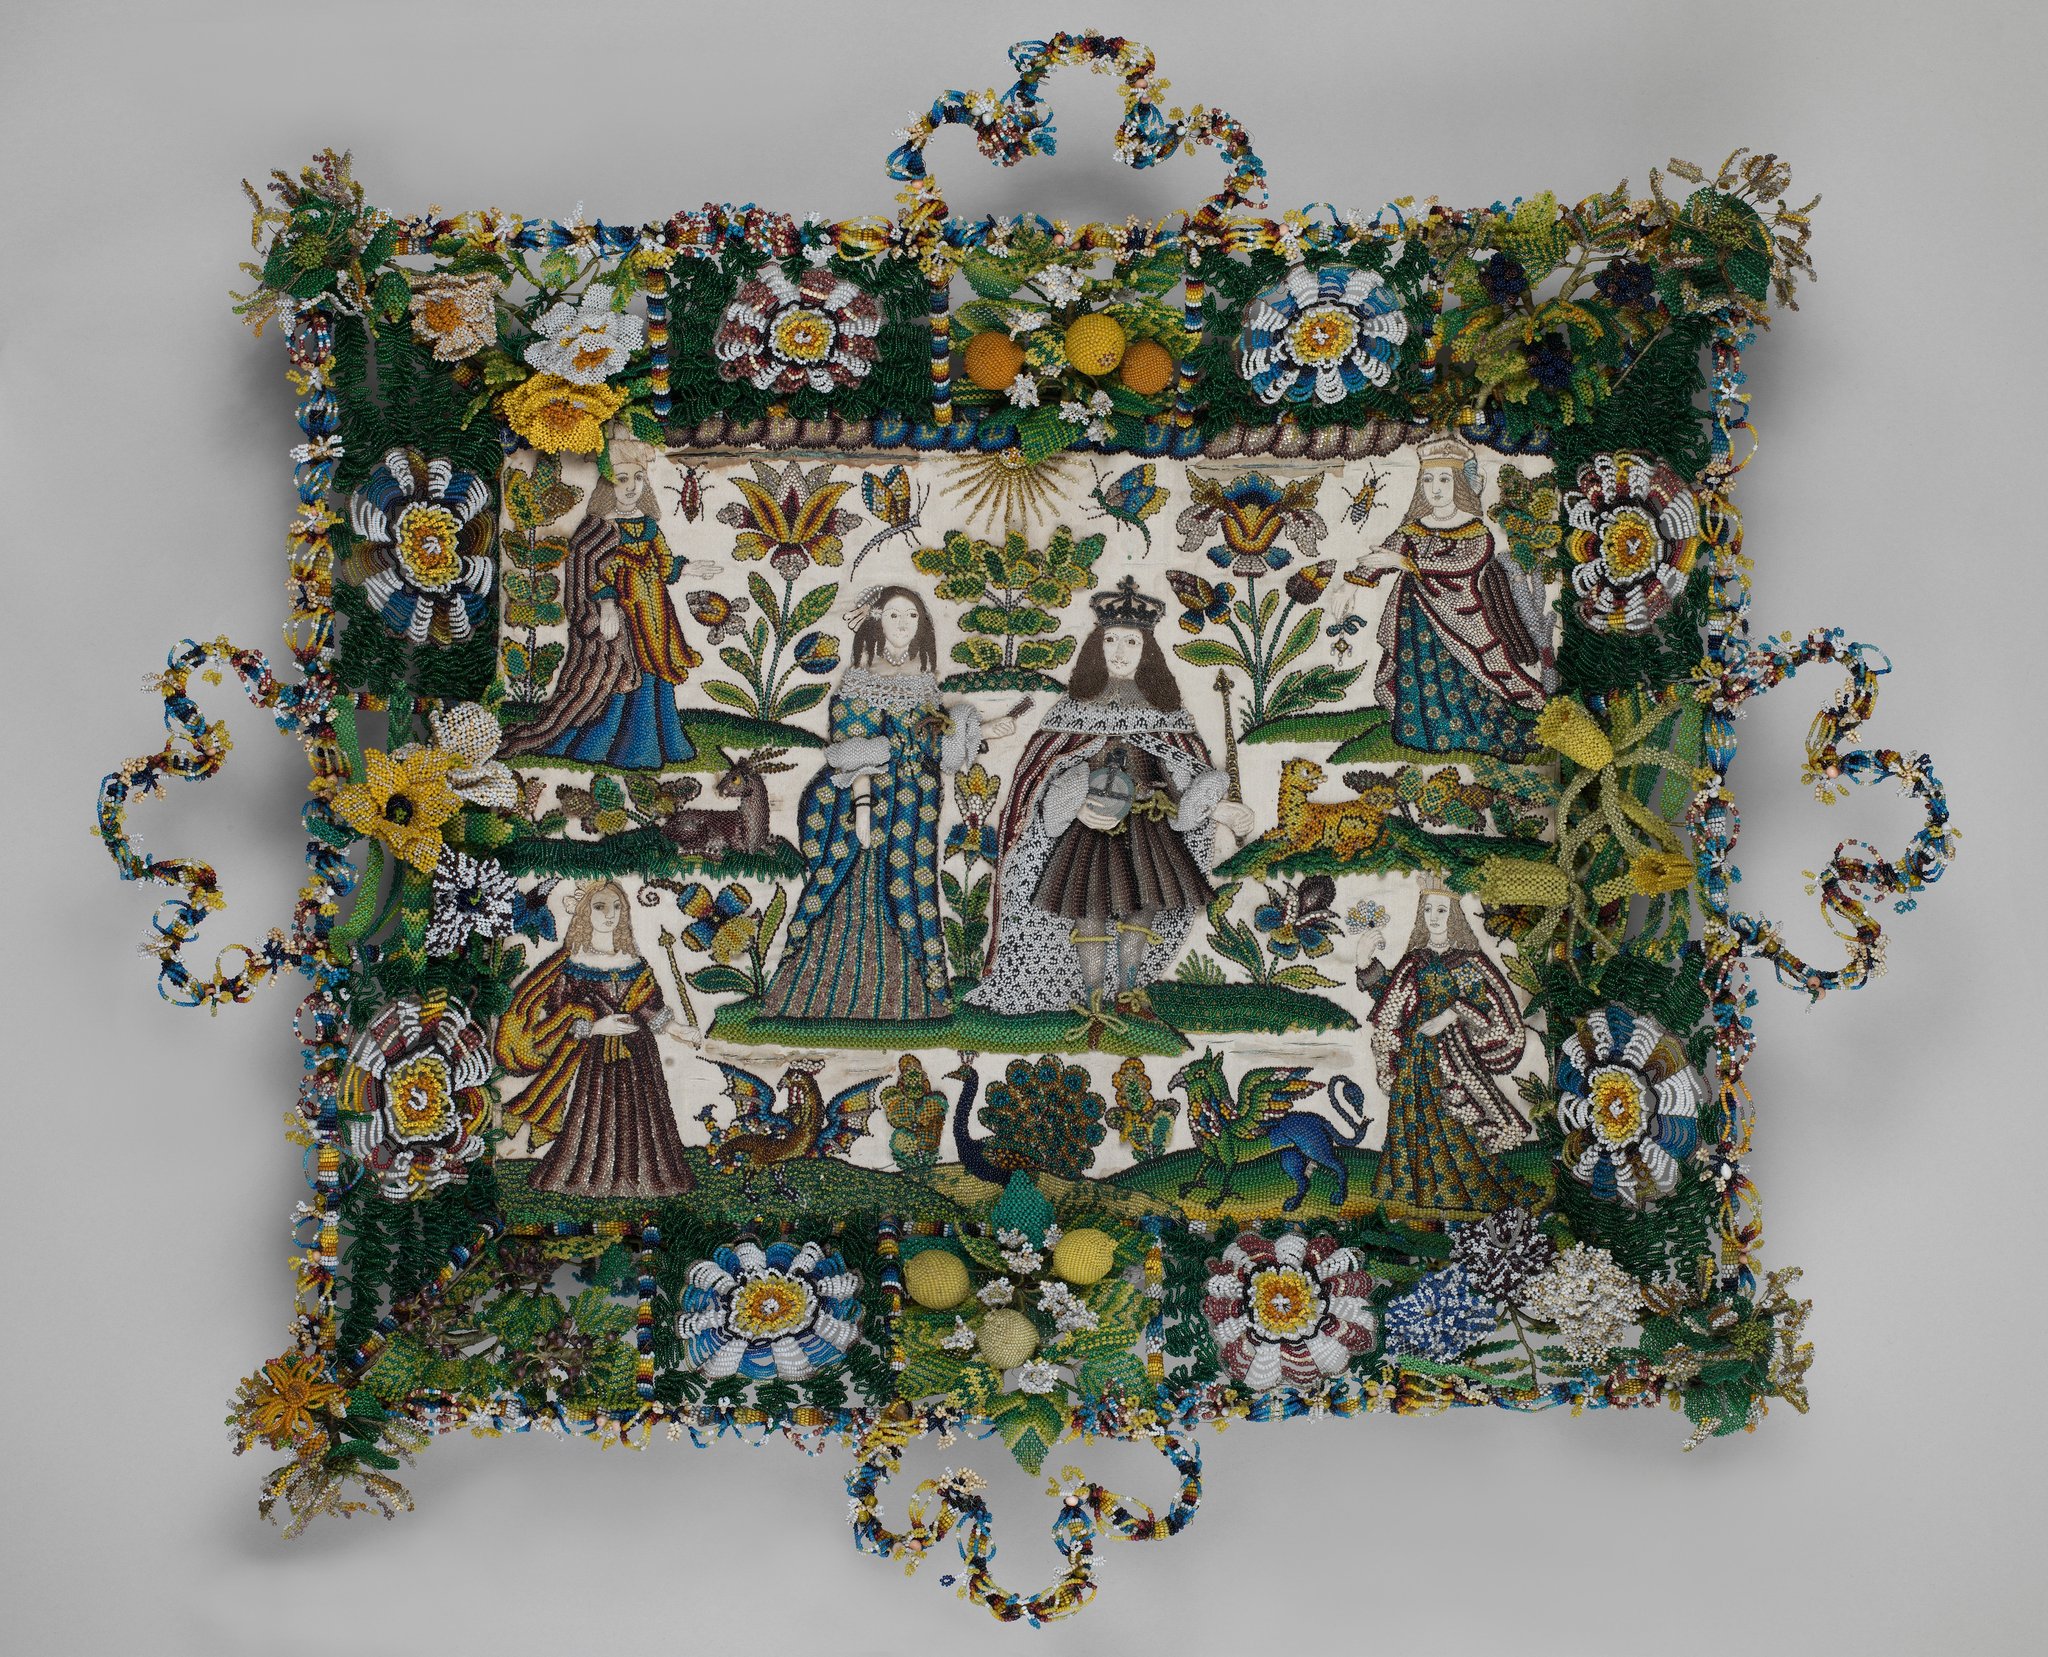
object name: basket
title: King Charles II and Catherine of Braganza with allegories of the four continents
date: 1662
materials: glass, silk, metal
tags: fruit,kings,women,griffins,peacocks,insects,leopards,flowers